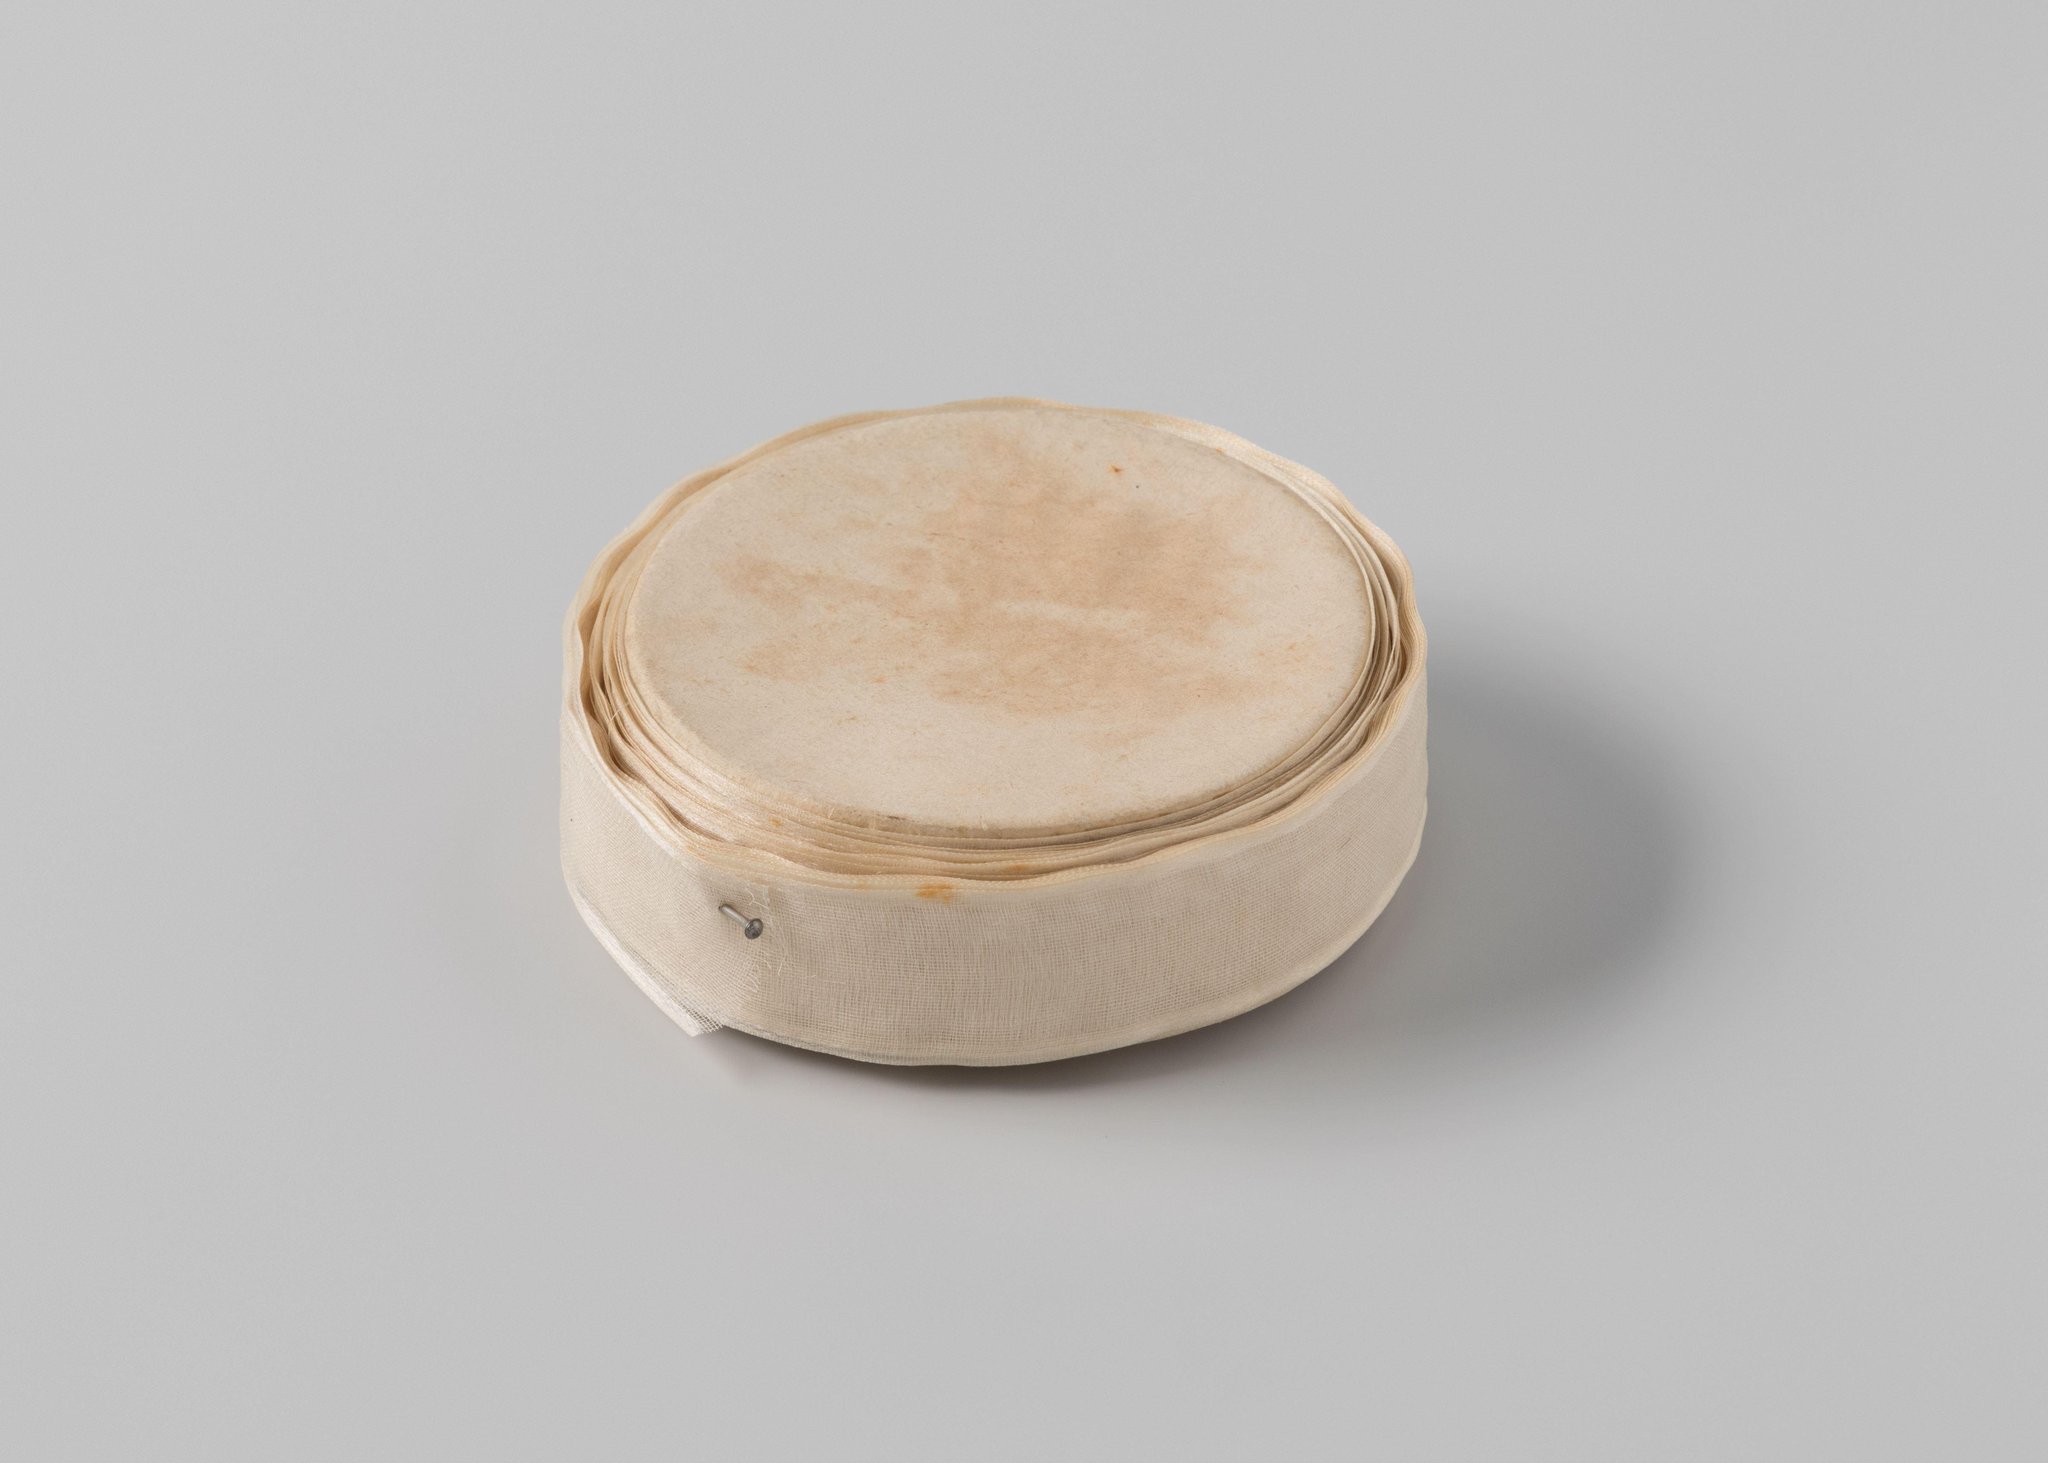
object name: ribbon material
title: Lint van crèmekleurig gaas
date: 1900-1915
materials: textile, silk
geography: nijmegen